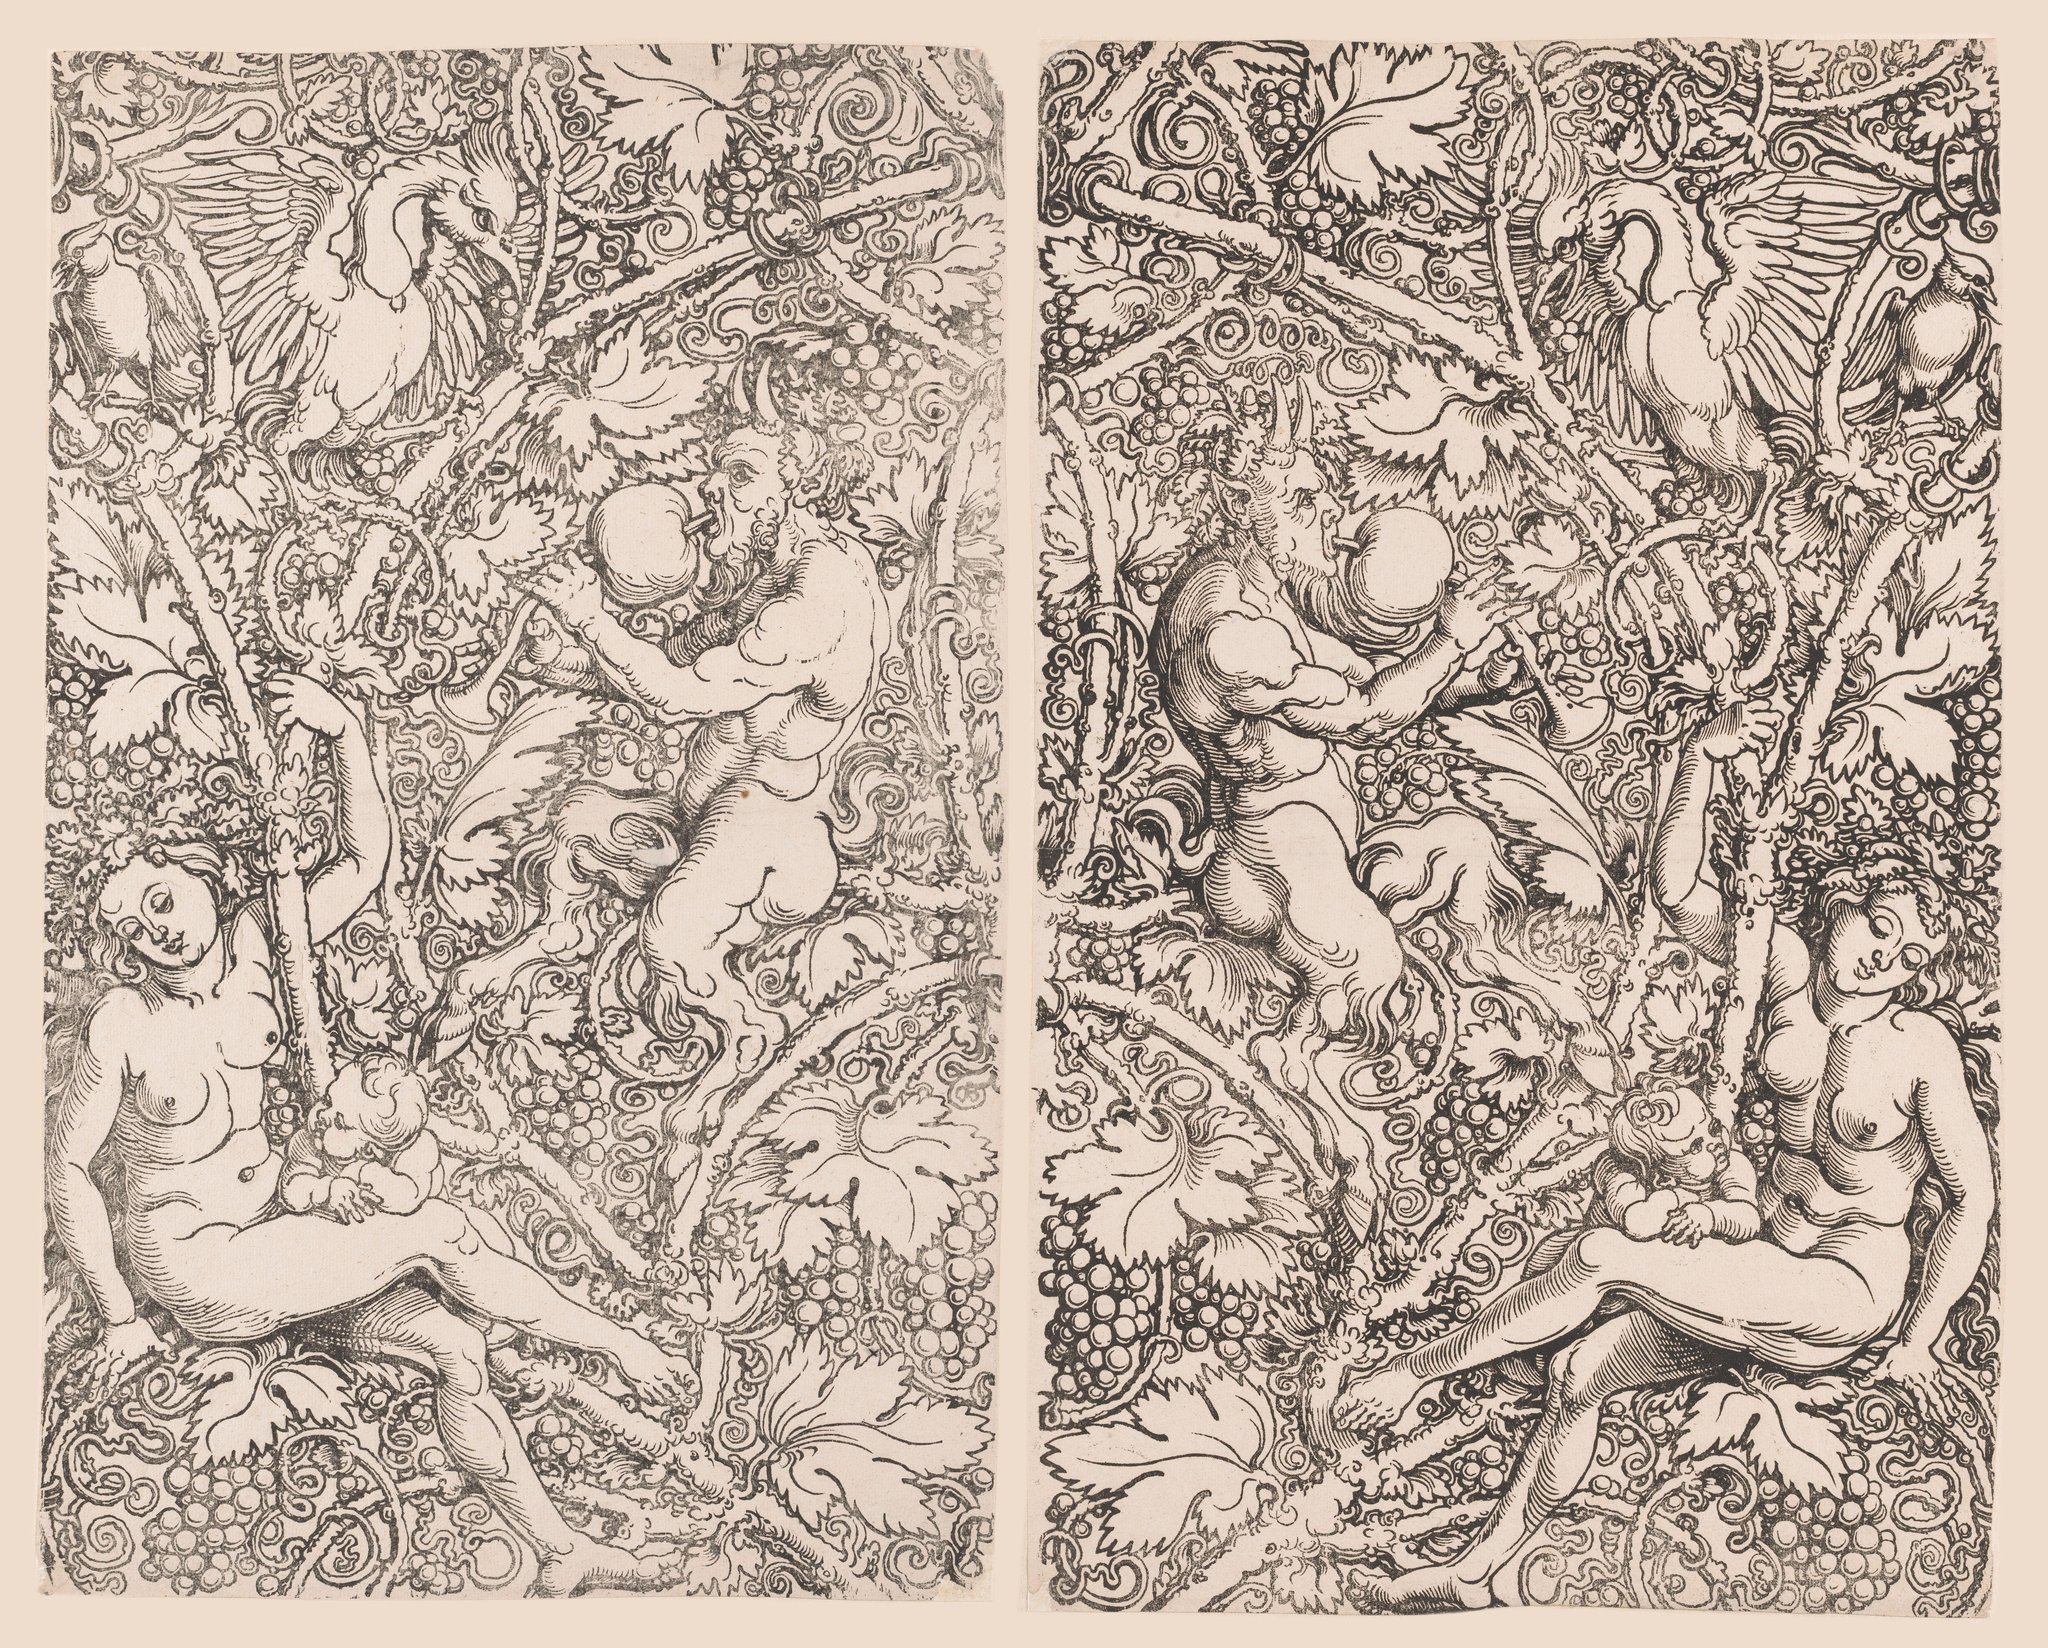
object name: print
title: Satyrfamilie tussen wijnranken, geheel bestaande uit twee delen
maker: Anonymous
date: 1510-1550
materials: paper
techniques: woodcut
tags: attributes of bacchus: vine, satyr(s) (in general), tapestry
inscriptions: collector's mark: Lugt 2228, collector's mark: Lugt 240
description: Dit object is omwille van een betere presentatie virtueel samengevoegd maar bestaat fysiek uit losse onderdelen. Ontwerp voor wandtapijt bestaande uit twee gespiegelde, maar niet identieke, delen.